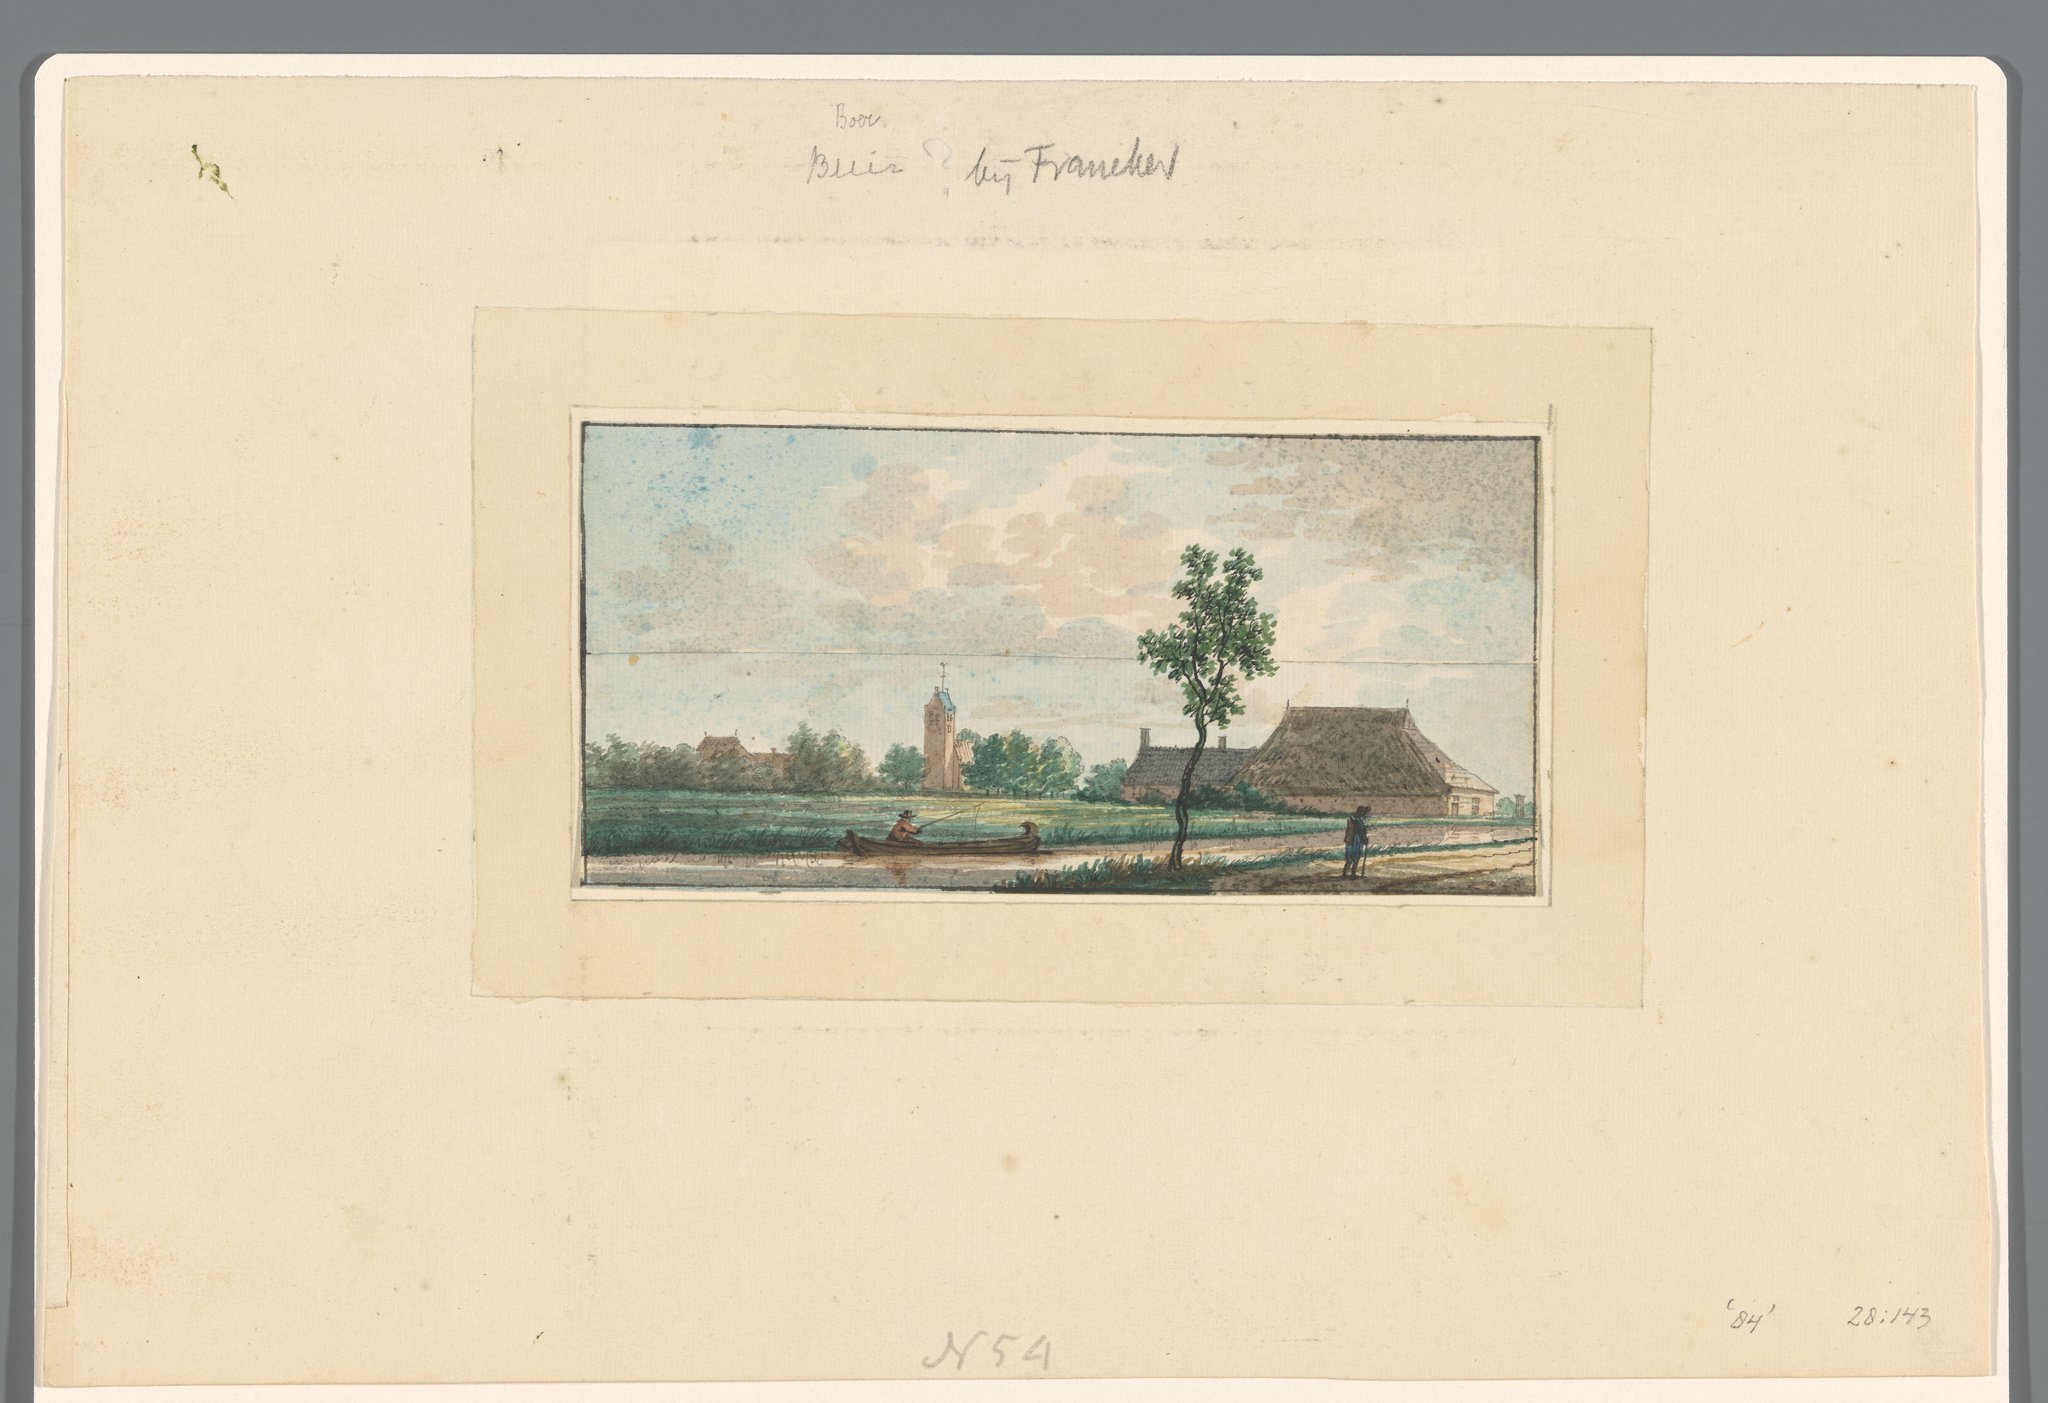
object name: watercolor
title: Gezicht op Boer, bij Franeker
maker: Anonymous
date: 1700-1800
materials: ink, paper, pencil, watercolor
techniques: brush, pen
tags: prospect of village, silhouette of village